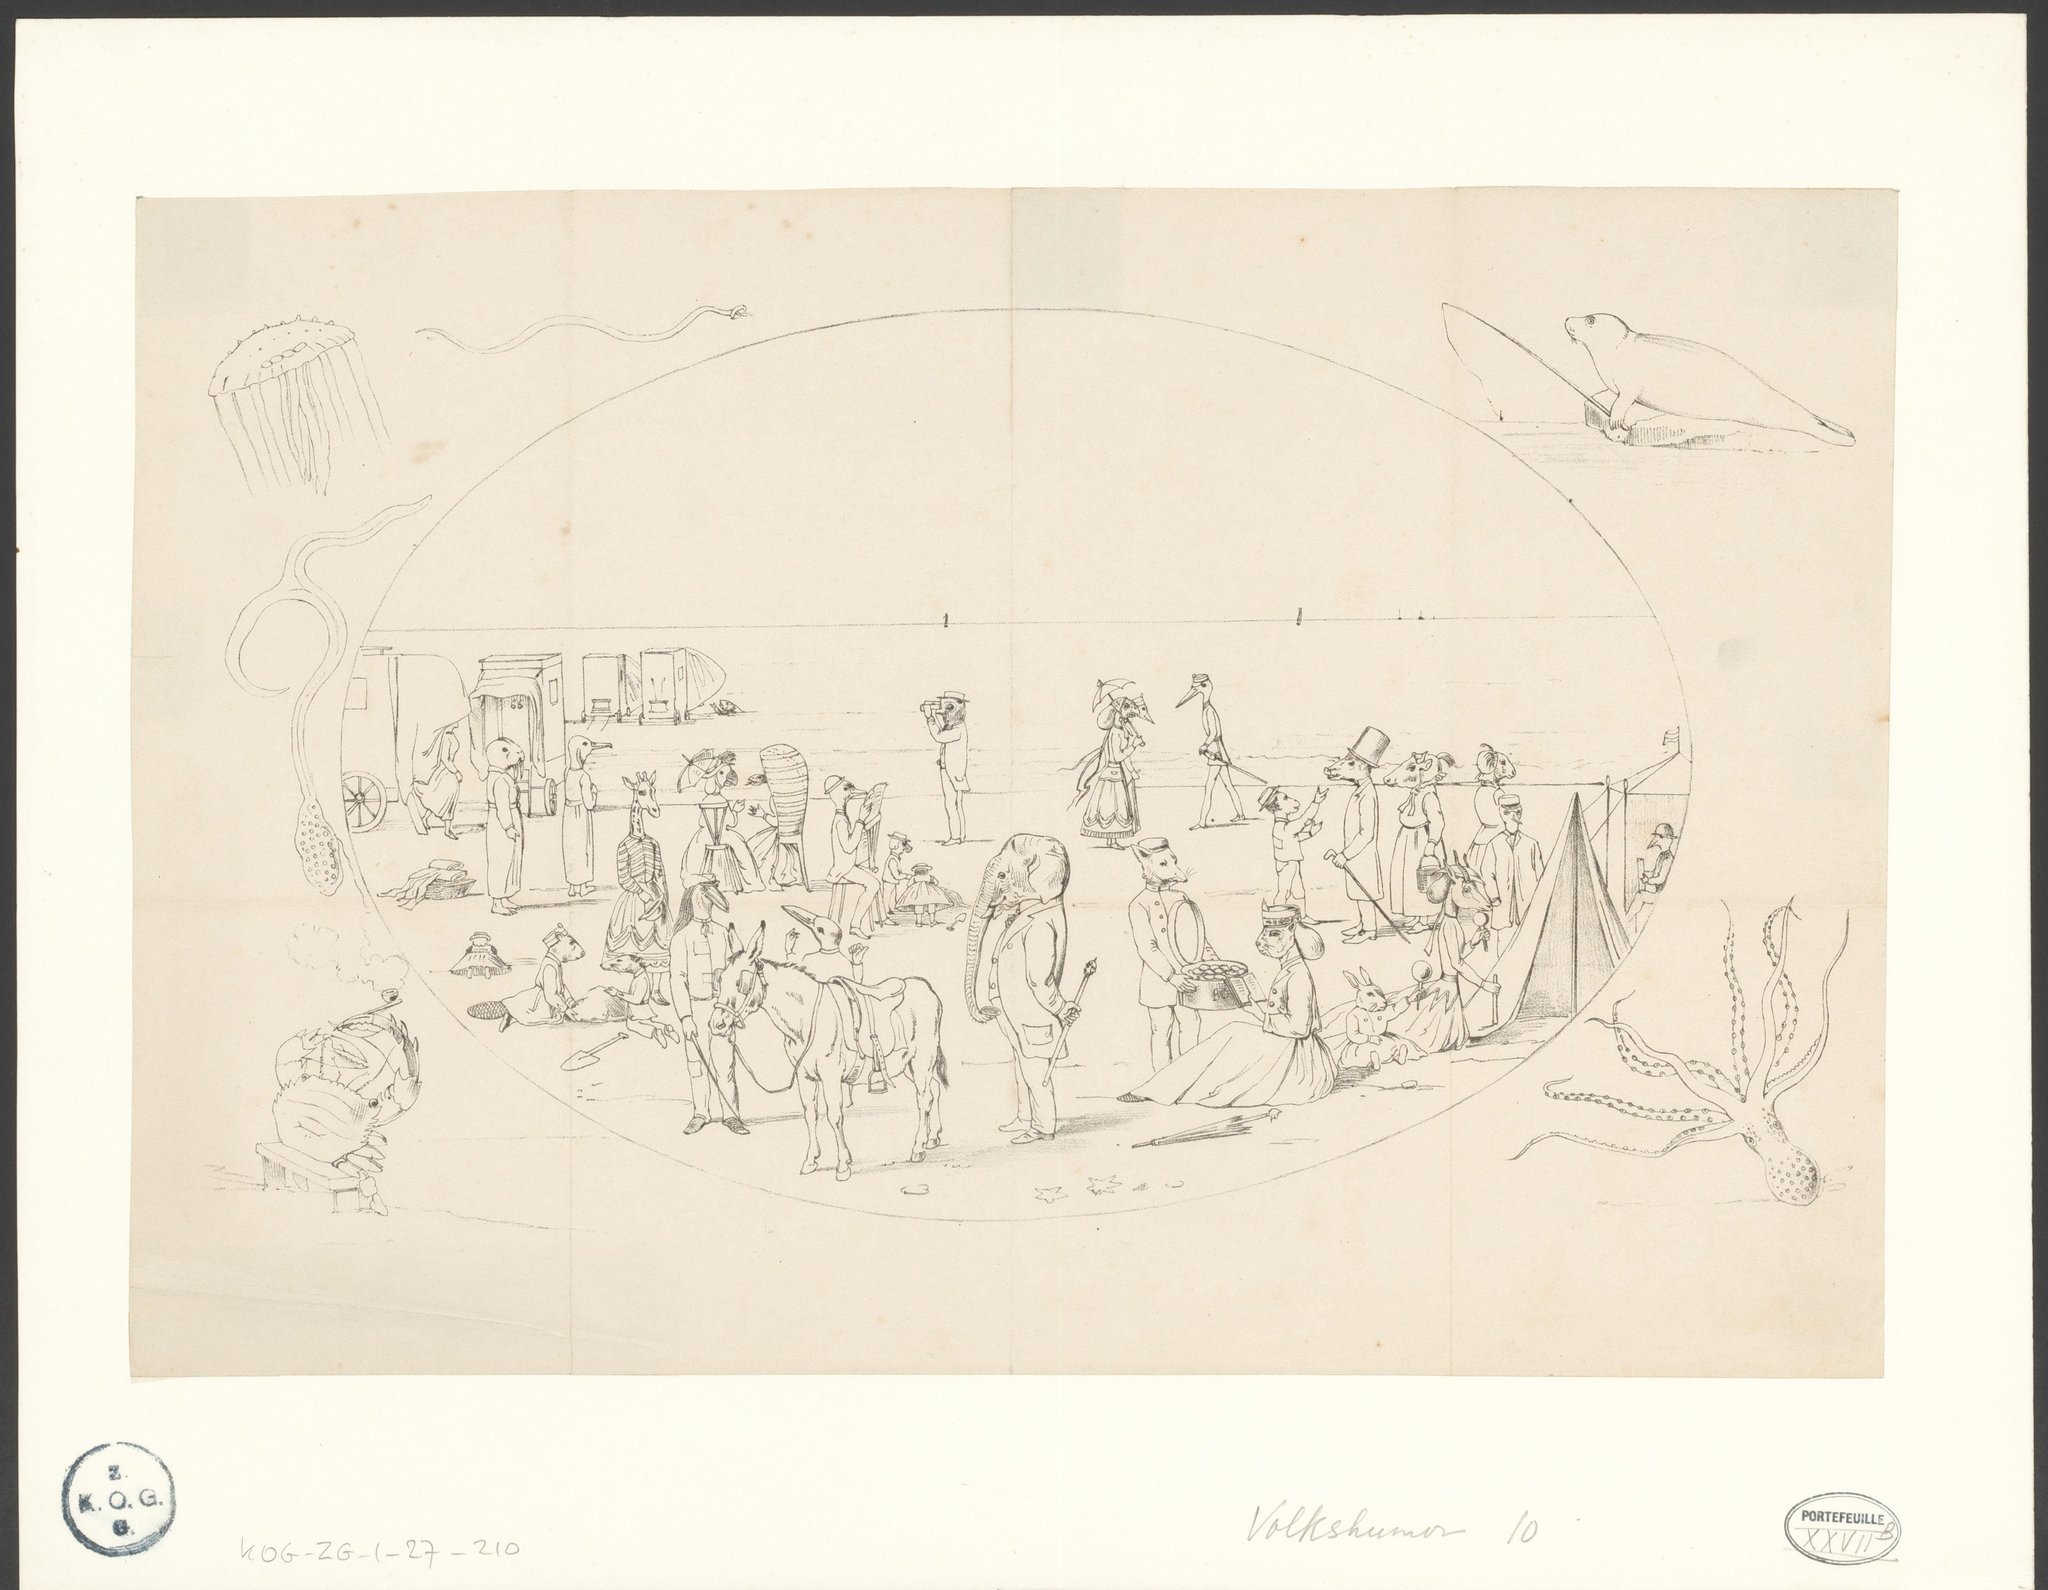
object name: cartoon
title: Strandleven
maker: Anonymous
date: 1850-1870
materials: paper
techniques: lithograph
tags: beach (as place of recreation), monsters of mixed human and animal shape; 'mostri' (ripa), animals acting as human beings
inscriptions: collector's mark: Lugt 1641, collector's mark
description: Spotprent op het strandleven waarin alle badgasten als dieren zijn voorgesteld. Ovale voorstelling met zeedieren in de vier hoeken van het blad. Onderwerpsrubrieken binnen de Atlas Zeden en Gewoonten: Volksleven; volkshumor, spot en bijgeloof.